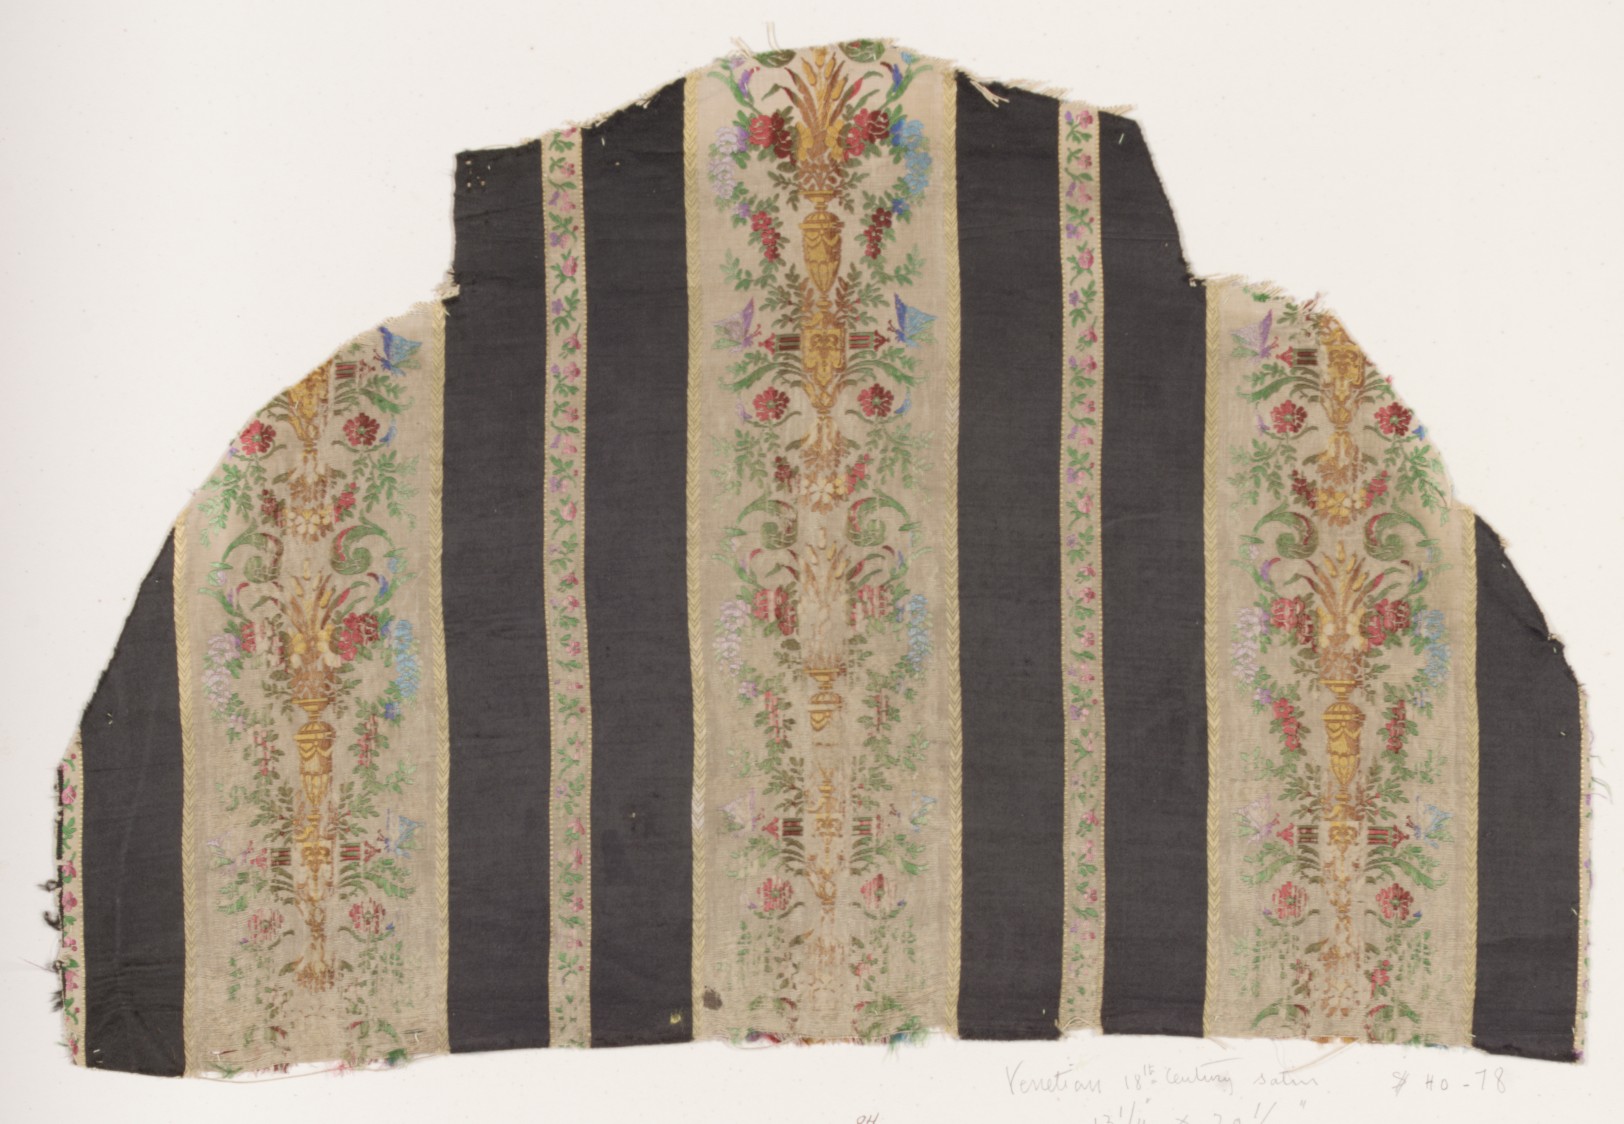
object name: fragment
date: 1801-1900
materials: silk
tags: flowers